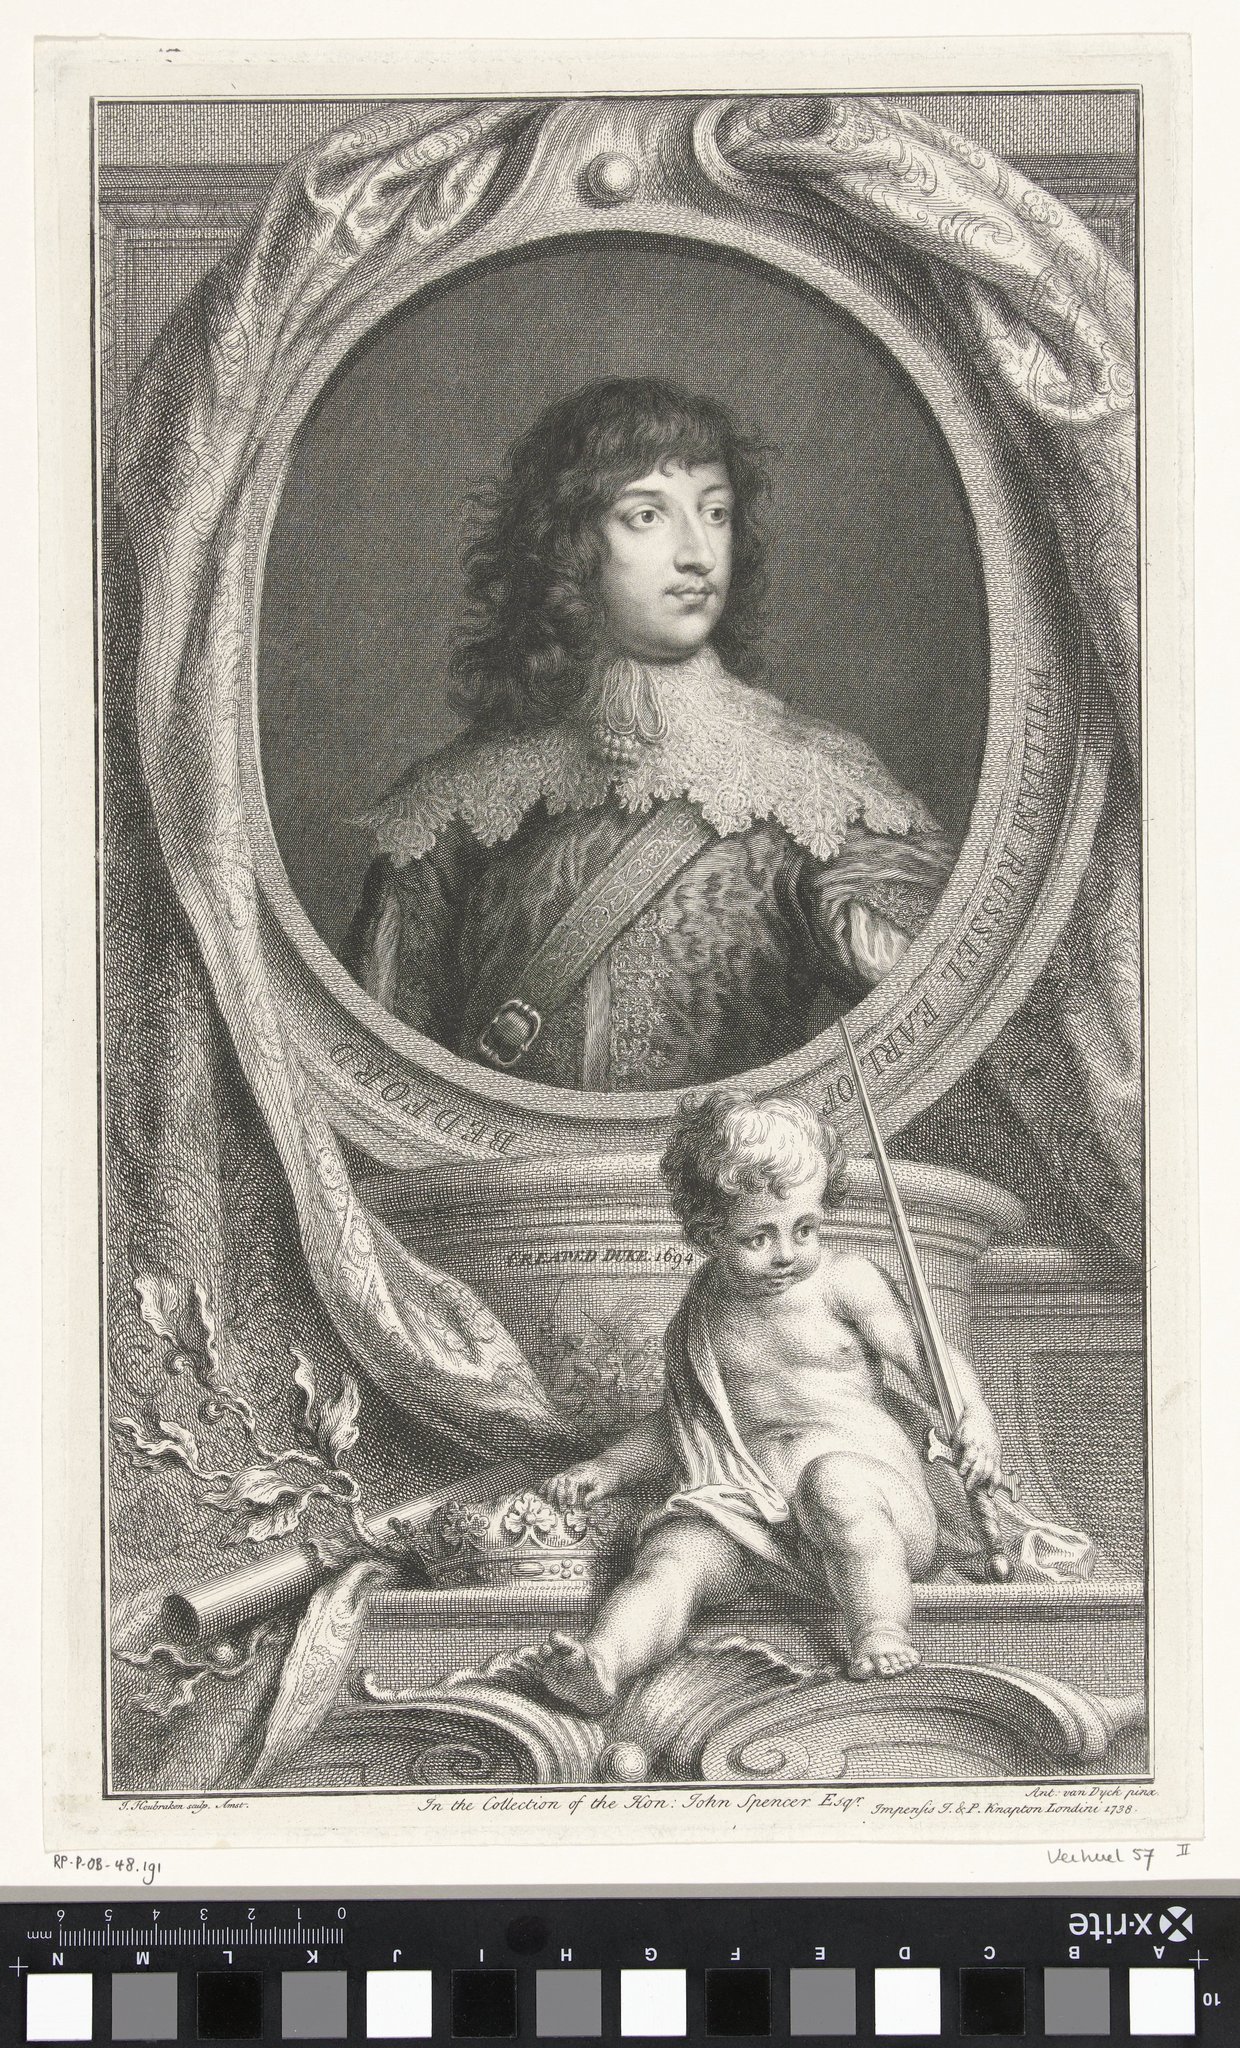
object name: print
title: Portret van William Russell, 1e graaf van Bedford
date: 1738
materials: paper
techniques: engraving, etching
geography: london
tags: hertog, william russell (1e hertog van bedford)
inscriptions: collector's mark: Lugt 240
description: Prent ook gebruikt in: Thomas Birch. The heads of illustrious persons of Great Britain : engraved by Houbraken, and Vertue, with their lives and characters. London: John en Paul Knapton, 1743-1751.